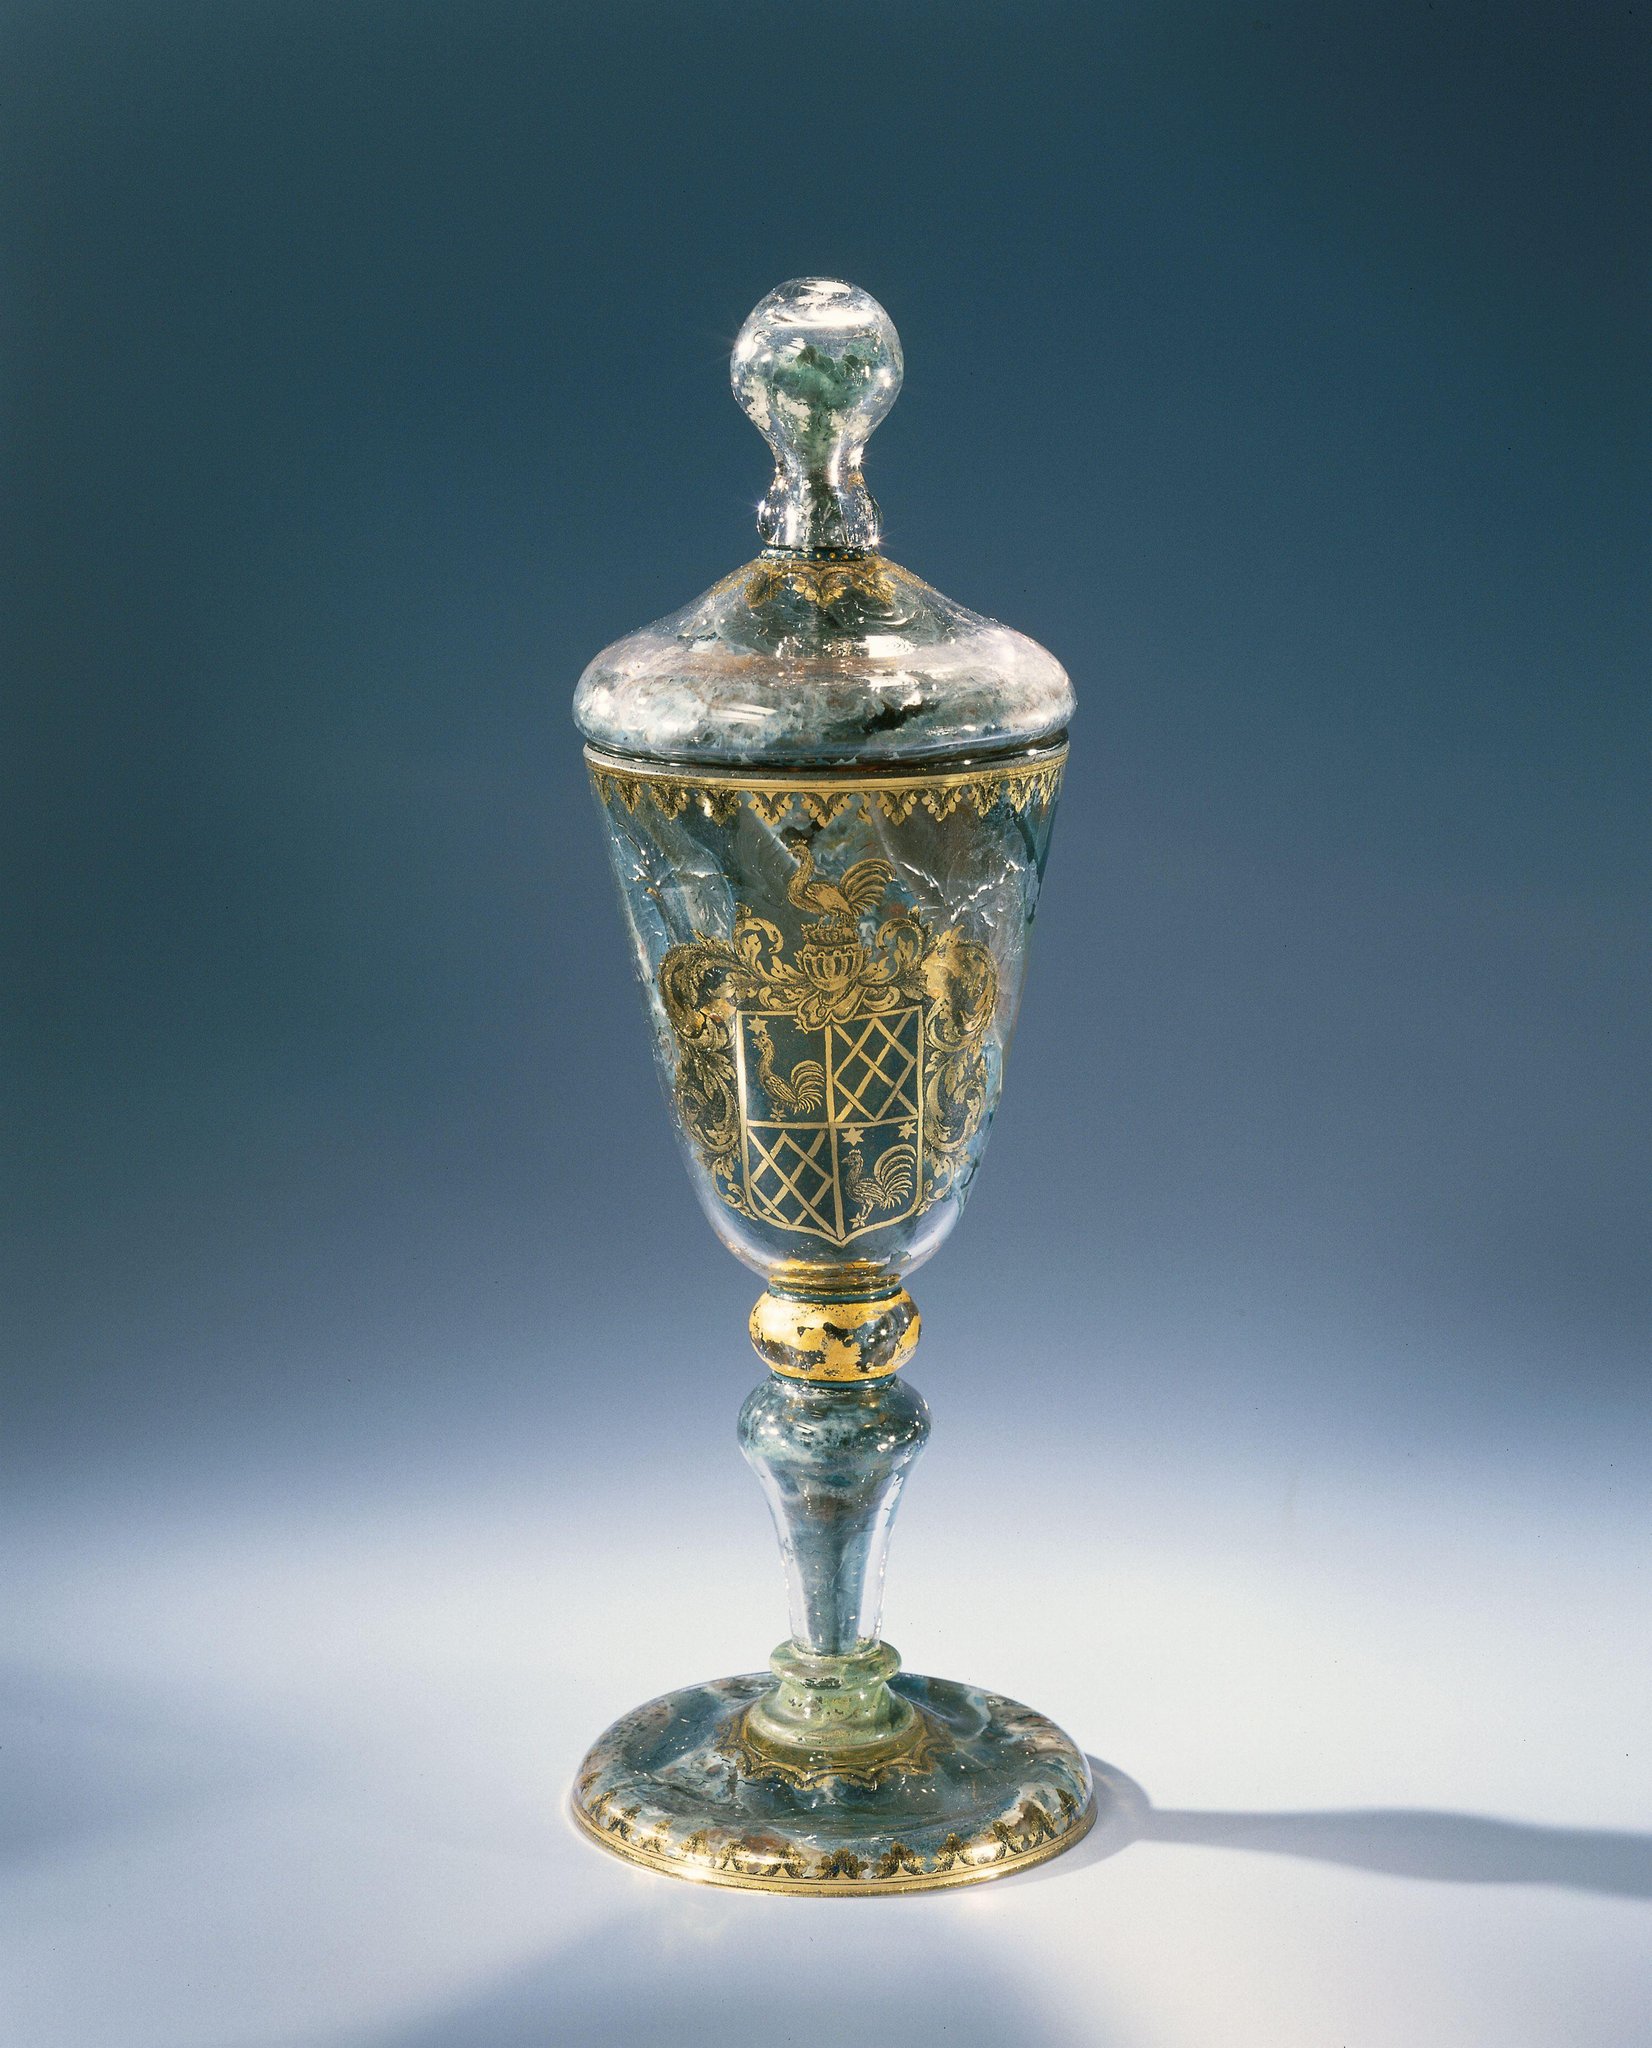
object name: goblet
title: Dubbelwandig bokaal , met het wapen van familie De Haen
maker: Anonymous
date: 1720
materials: glass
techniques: glassblowing, painted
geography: dresden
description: Licht gewelfde voet, dubbele manchet onder een holle, balustervormige stam, waarboven een holle afgeplatte nodus onder een trechtervormige, aan de onderzijde afgeronde kelk. Licht gewelfd deksel met holle gebogen knop. De voet, de kelk en het deksel dubbelwandig en tussen de wanden beschilderd in blauw-grijs in een marmermotief. De onderkant van de voet, de binnenkant van de kelk en de onderkant van het deksel van binnen uit verguld. De holle stam, nodus en knop van het deksel van binnen uit gemarmerd. De manchet aan de buitenzijde gemarmerd, de nodus aan de buitenzijde verguld. Langs de voetrand, de overgang van voet naar manchet en de rand van de kelk vergulde en gegraveerde palmetten. Op de kelk in goud het wapen van de Amsterdamse koopmansfamilie De Haen, omgeven door loofwerk en bekroond door een gesloten vizier met als helmteken een haan. Het wapen: 1 en 4 een naar links gewende haan en drie sterren en 2 en 3 latwerk. Kitranden aan de onderzijde van voet en deksel en enige millimeters onder de rand van de kelk, aan de buitenzijde.